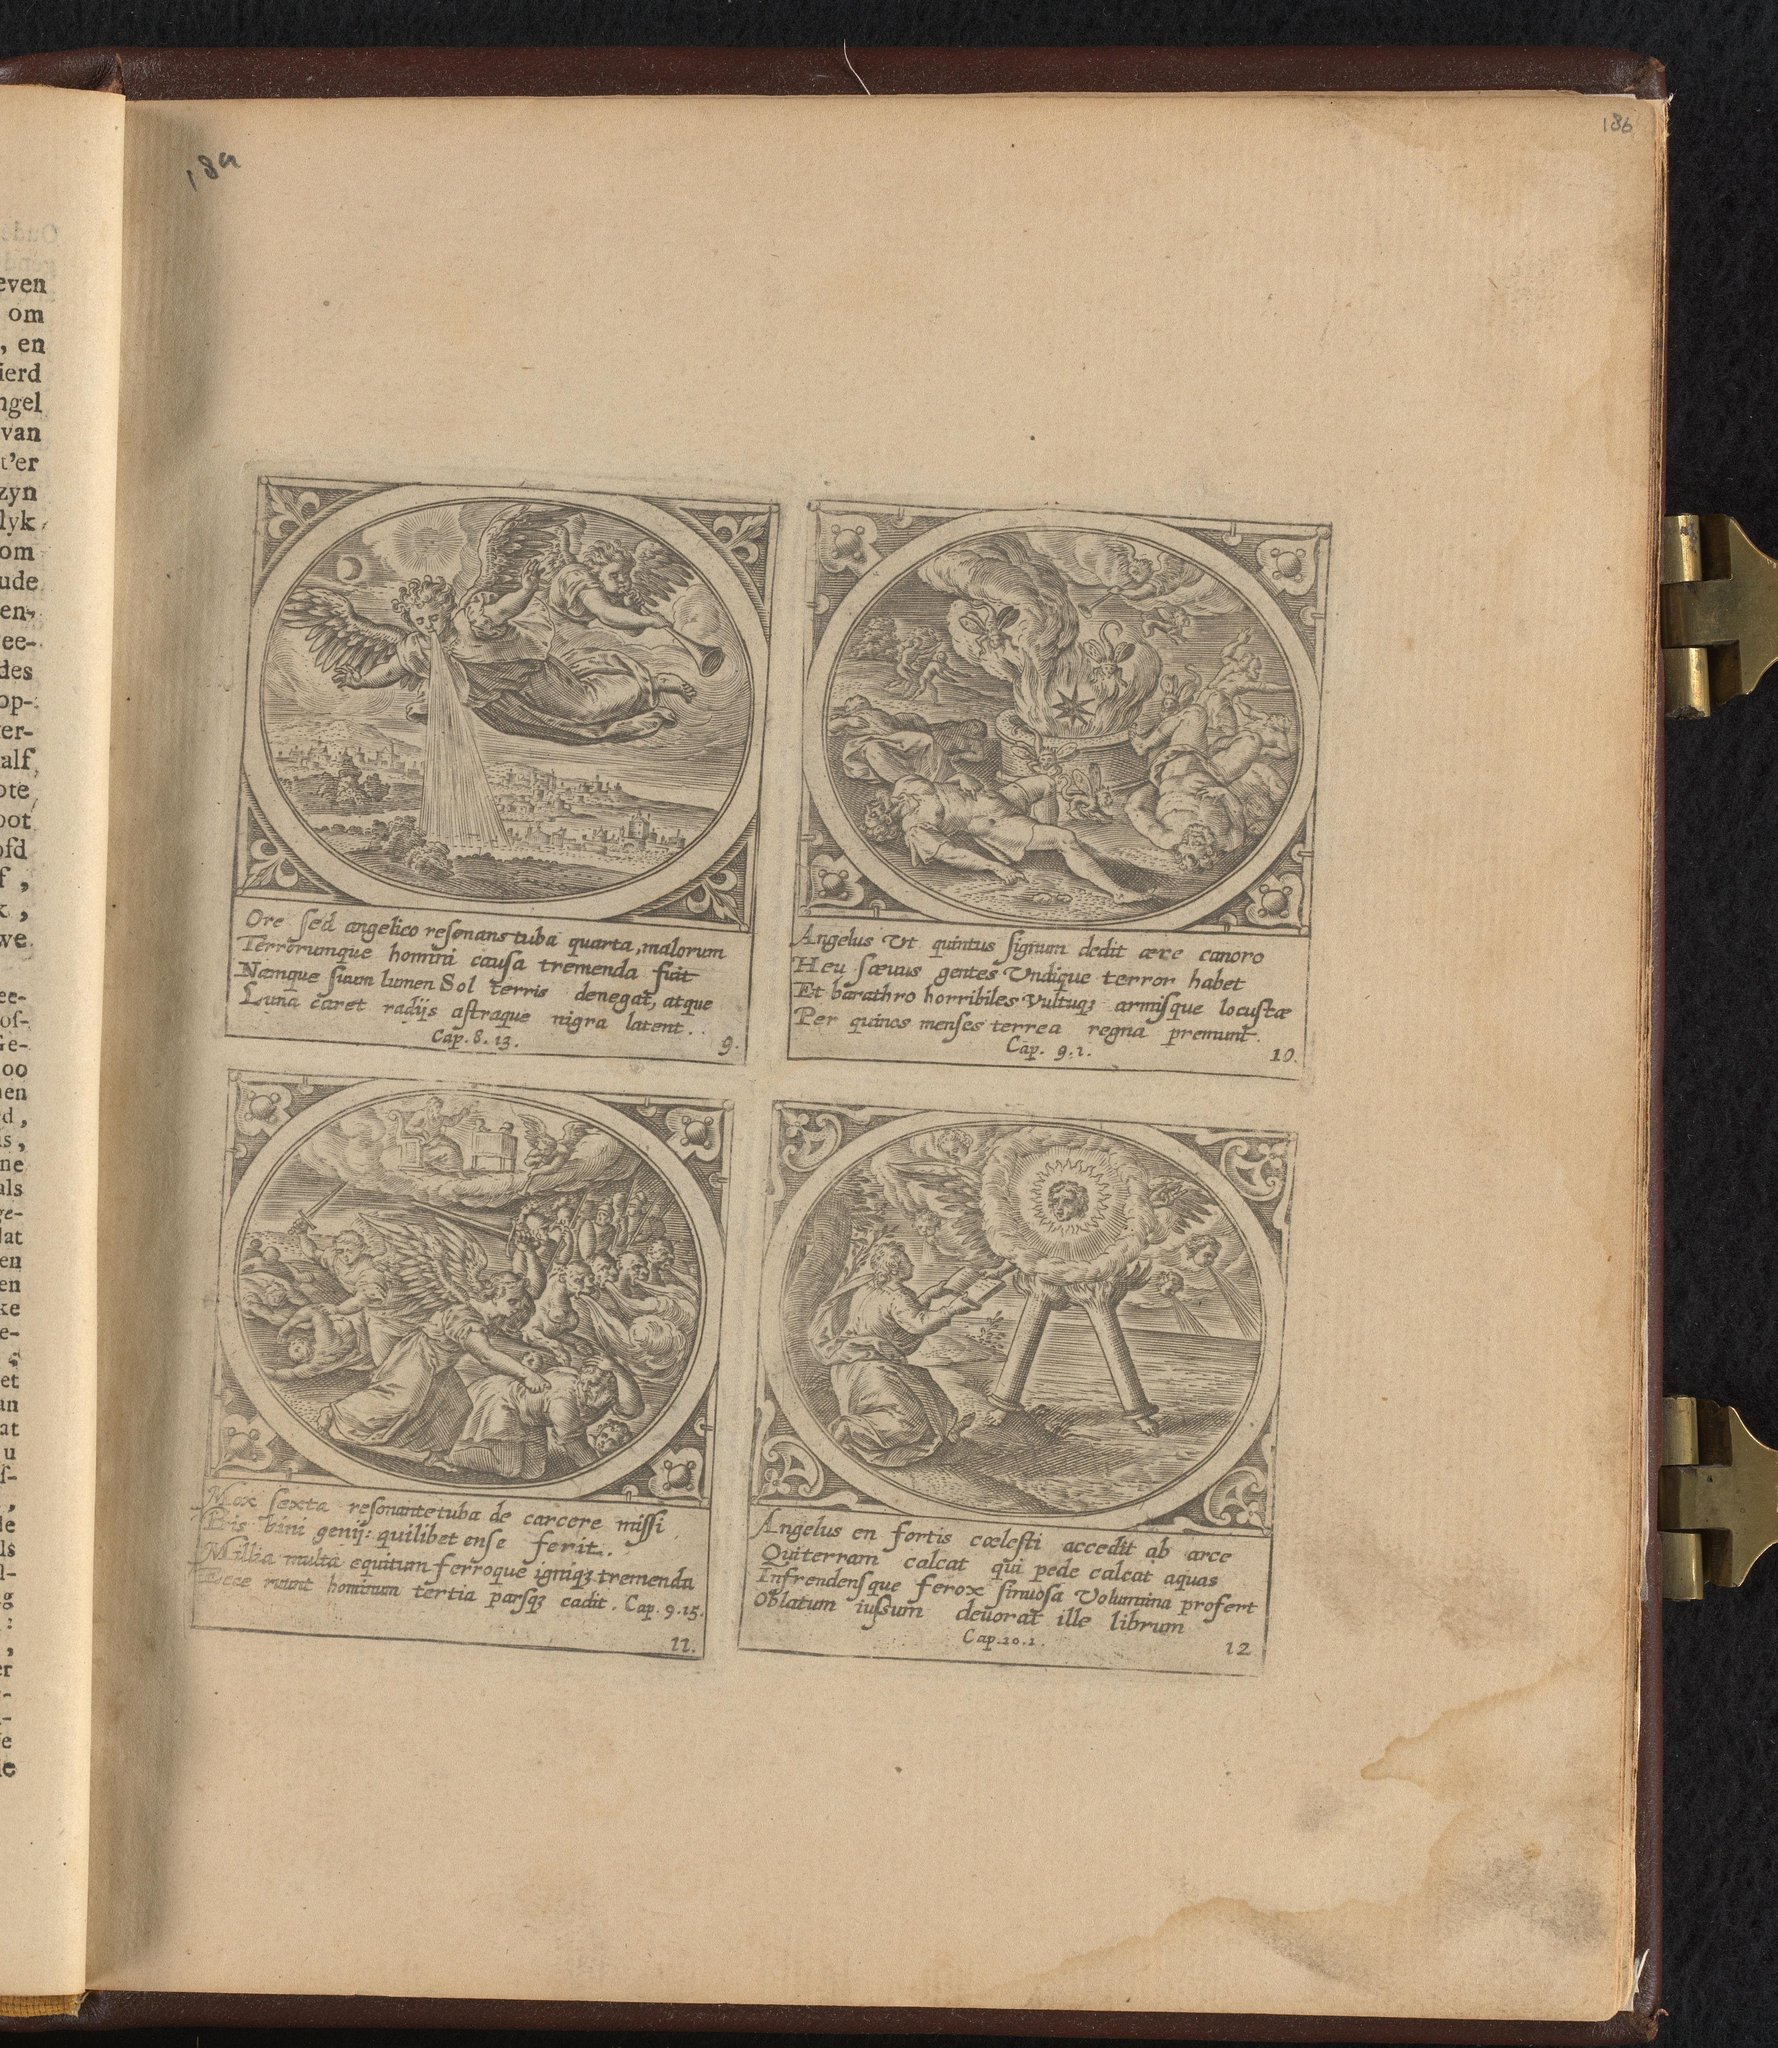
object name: album leaf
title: Engelen blazen op bazuinen en Johannes de Evangelist ontvangt het heilig geschrift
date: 1585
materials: paper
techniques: engraving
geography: southern netherlands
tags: the fifth of the seven angels sounds the trumpet: the falling star opens up the bottomless pit: smoke comes out, the sixth of the seven angels sounds the trumpet: the four angels of destruction are released, the mighty angel with the little open book in his hands: he is wrapped in a cloud; his legs are pillars of fire, which stand one on land and one in the sea ~ apocalypse, the fourth of the seven angels sounds the trumpet: the sun, the moon and the stars are partially darkened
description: Onversneden blad met vier prenten uit dezelfde serie, rechtsonder genummerd van 9 tot en met 12. Prenten maken deel uit van een prentbijbel.